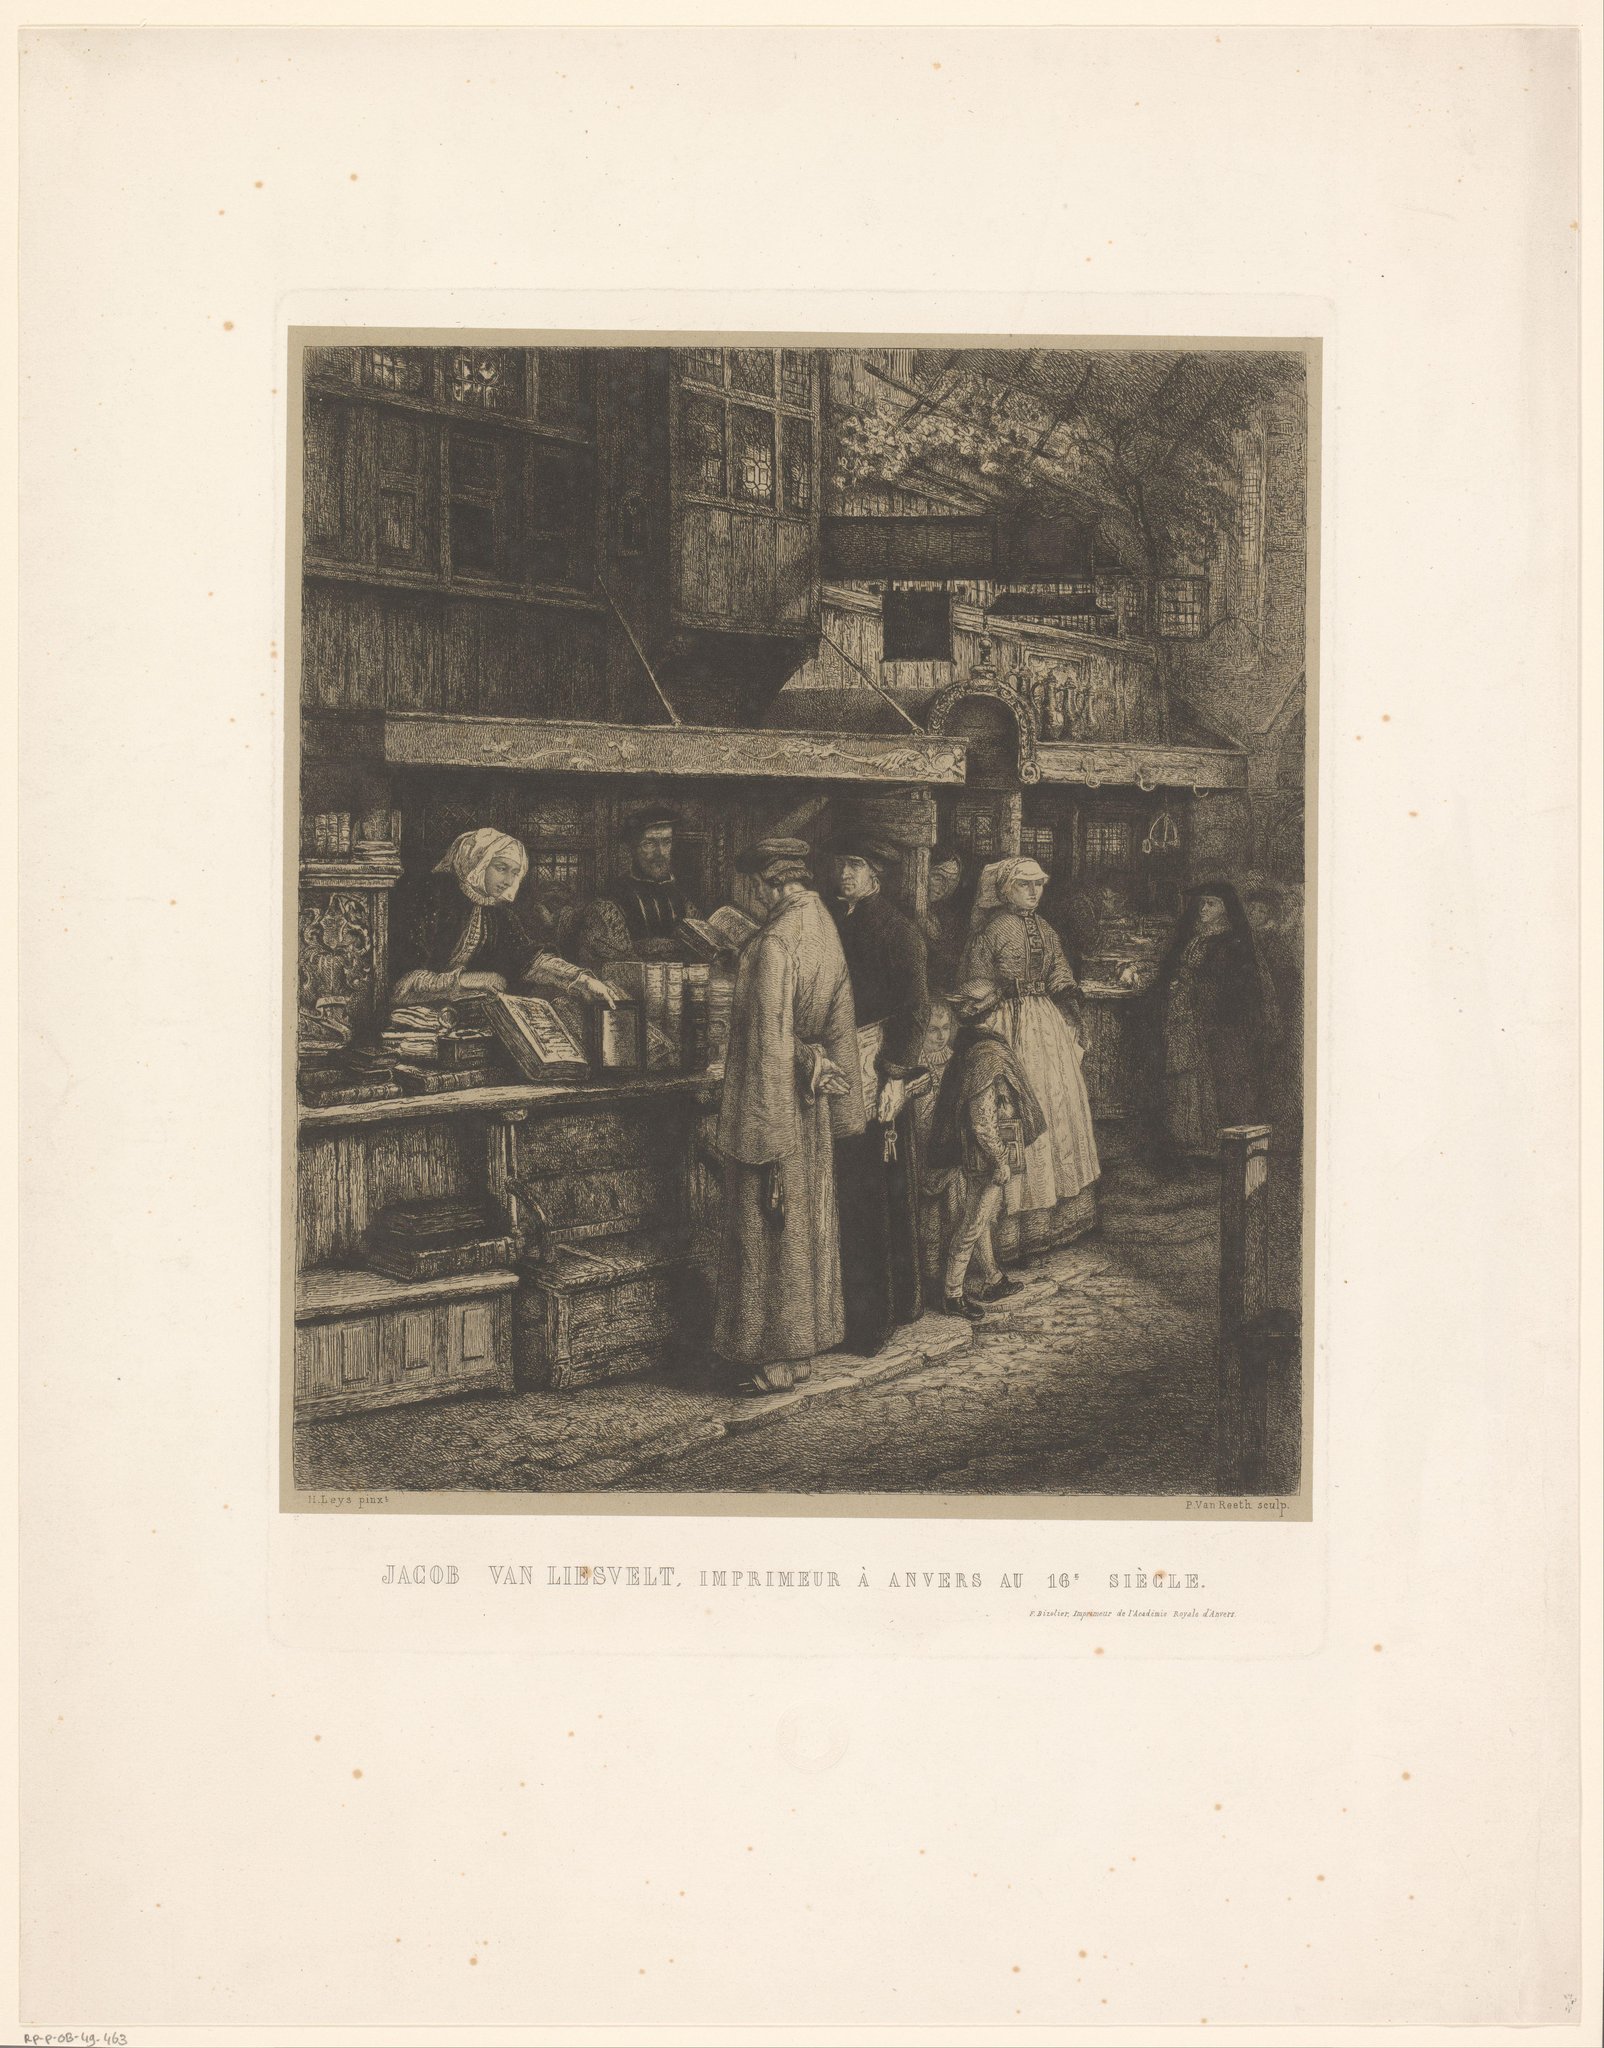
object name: print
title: Jacob van Liesvelt, impimeur à Anvers au 16e siècle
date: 1832-1866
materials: paper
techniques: etching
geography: antwerp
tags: printer, book-stall, kiosk, house combined with shop, street, antwerp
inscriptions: check stamp: ‘wt jonsten versaemt’